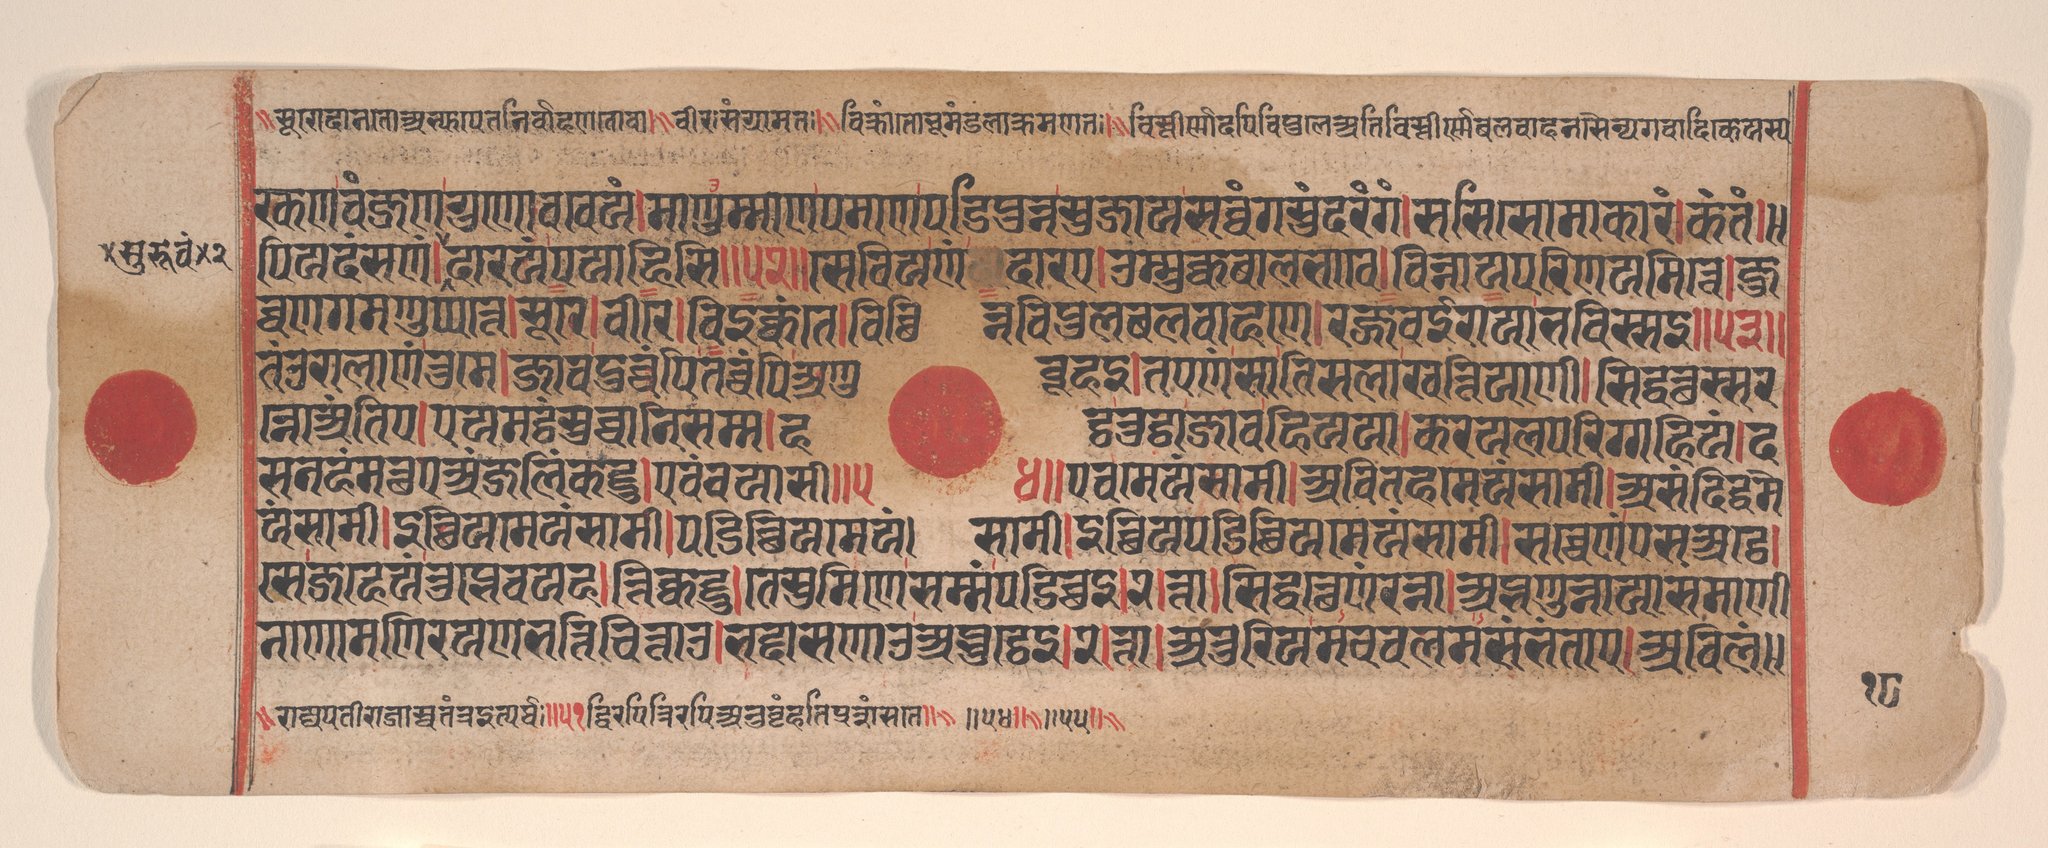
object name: folio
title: Leaf from a Kalpa Sutra (Jain Book of Rituals)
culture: indian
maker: bhadrabahu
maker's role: artist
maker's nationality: indian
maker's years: 356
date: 1401-1500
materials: gold, ink, paper, watercolor